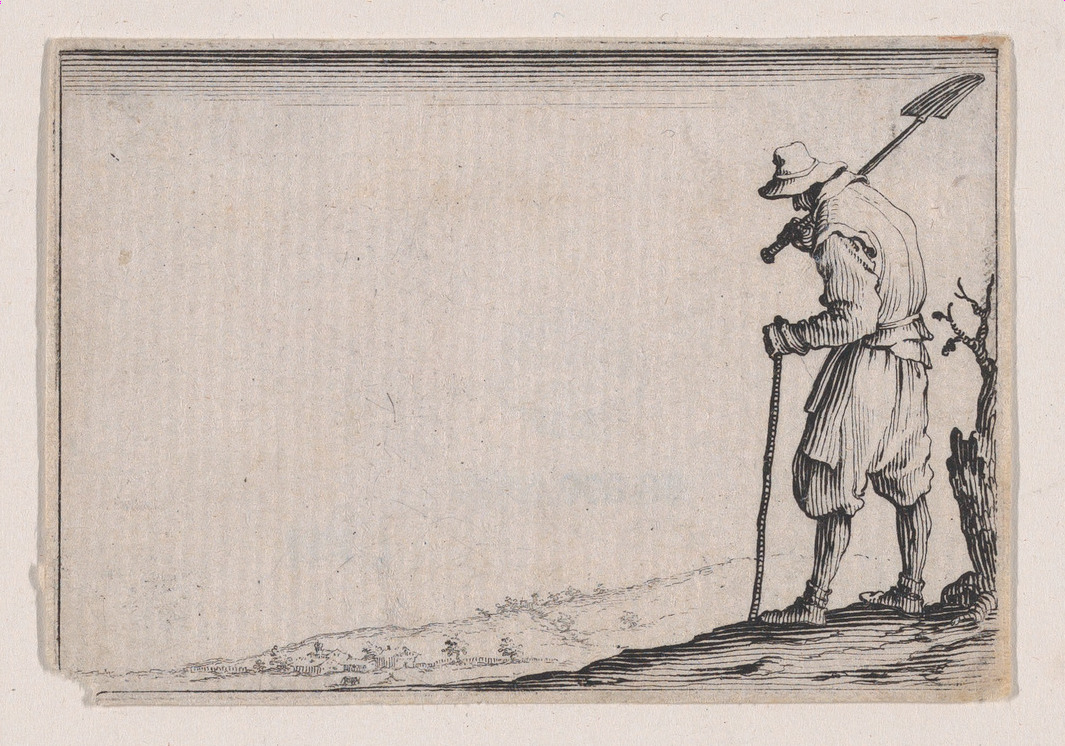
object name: print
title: Le Paysan Portant sa Pelle sur L'Épaule (The Peasant Carrying his Shovel on his Shoulder), from Les Caprices Series A, The Florence Set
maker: jacques callot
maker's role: artist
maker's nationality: french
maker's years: 1592-1635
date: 1617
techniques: etching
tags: men